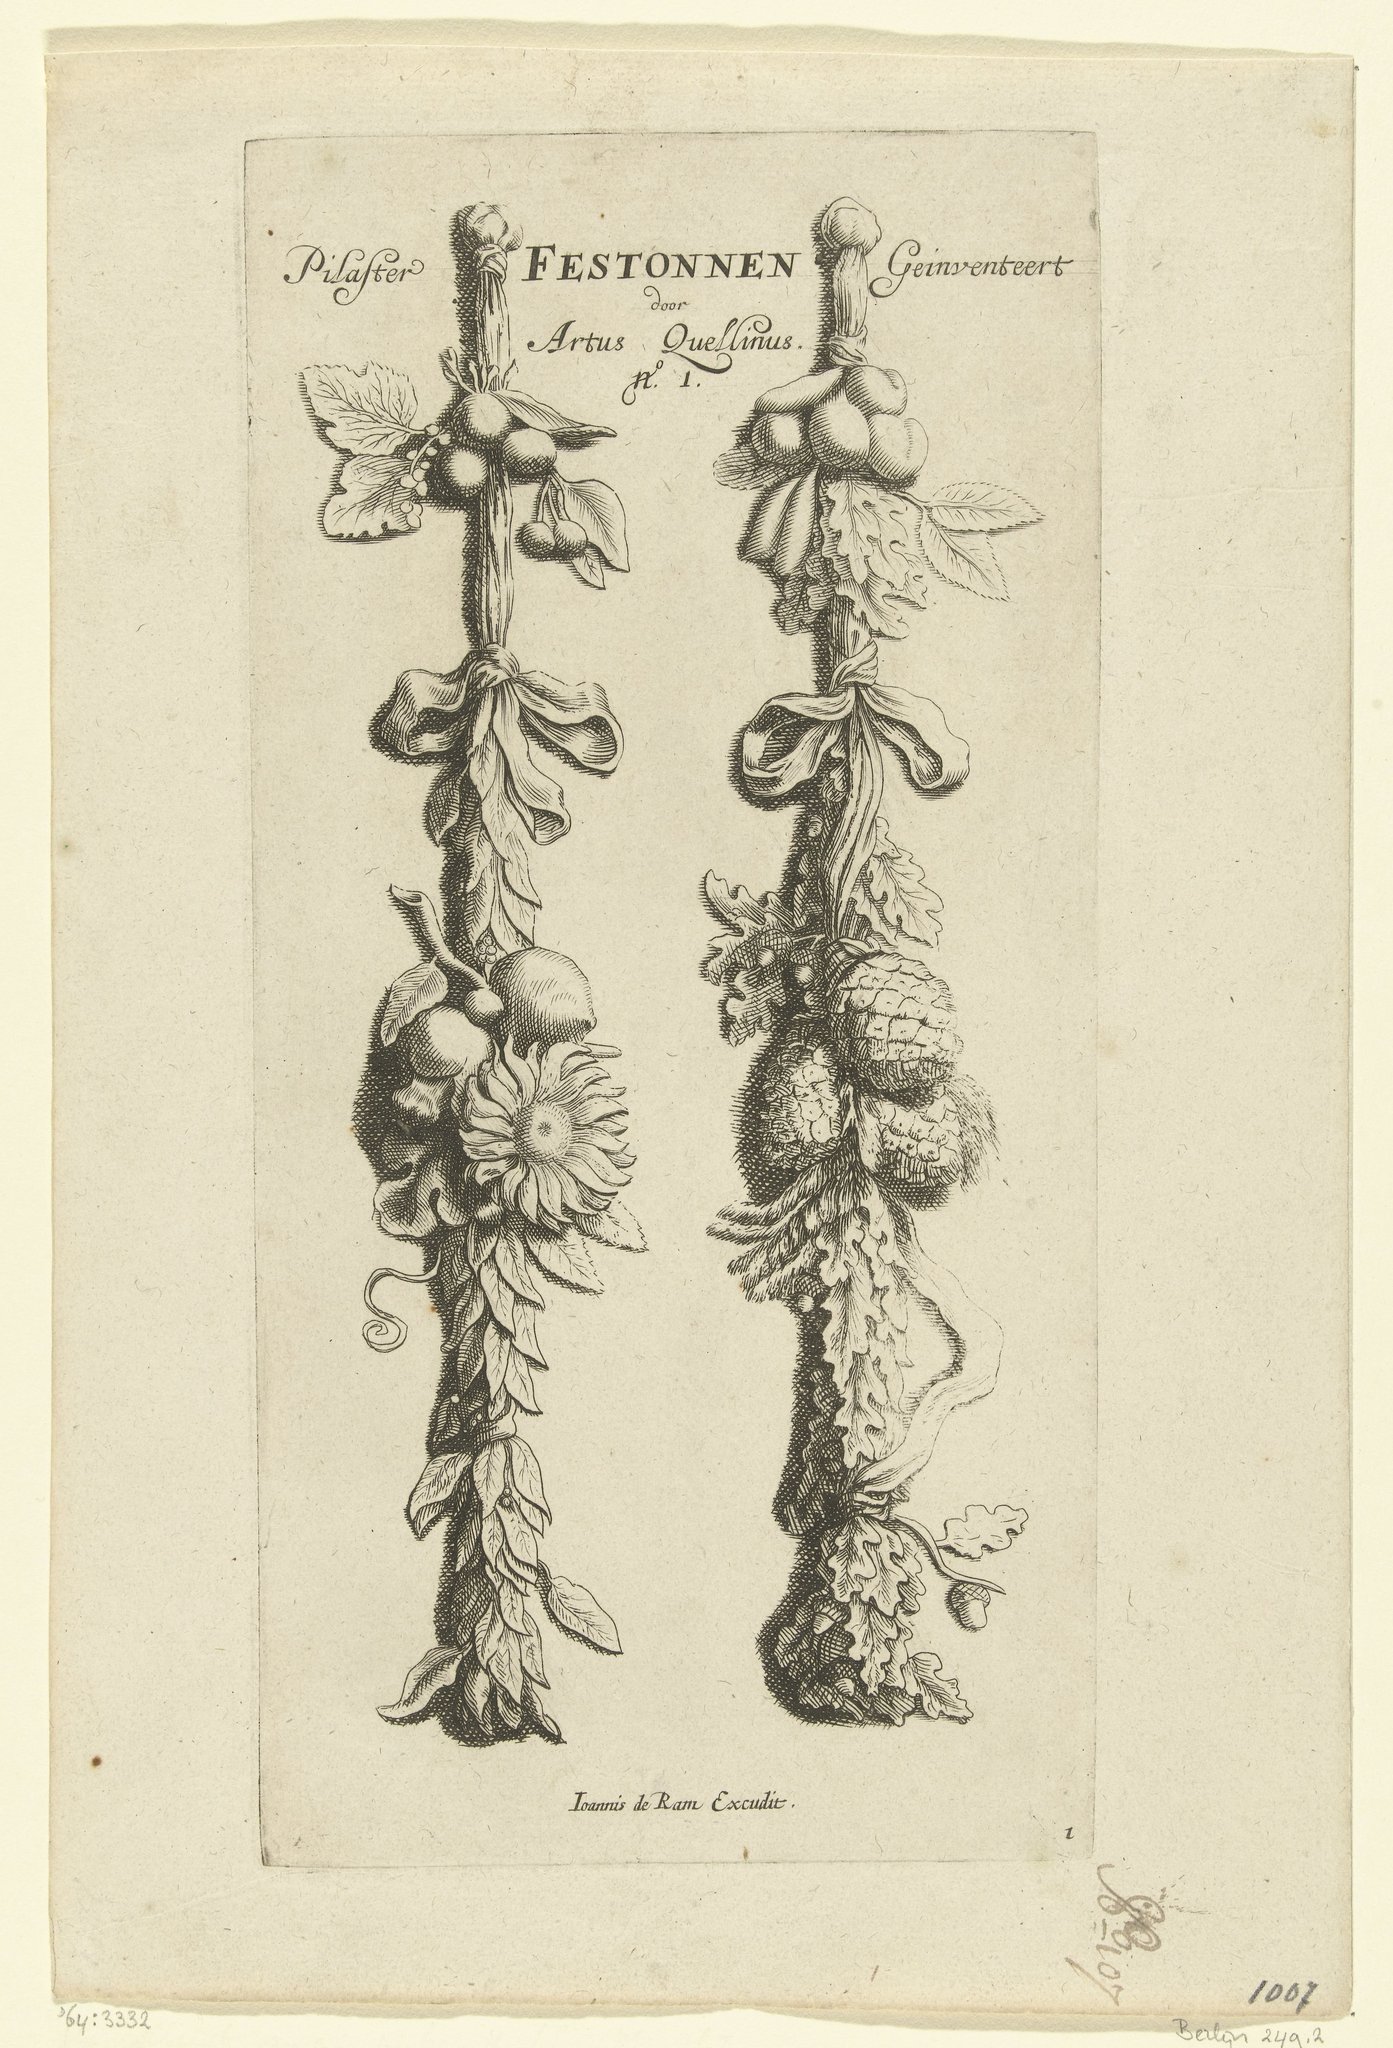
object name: ornament print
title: Titelblad: Pilaster Festonnen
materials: paper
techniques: engraving, etching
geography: amsterdam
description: Tegenzijdige kopie naar festoenen uit de serie Prima Pars Praecipuarum.../ Het Eerste Deel Van de voornaemste Statuen ende Cieraten.../ La Premier Partie....